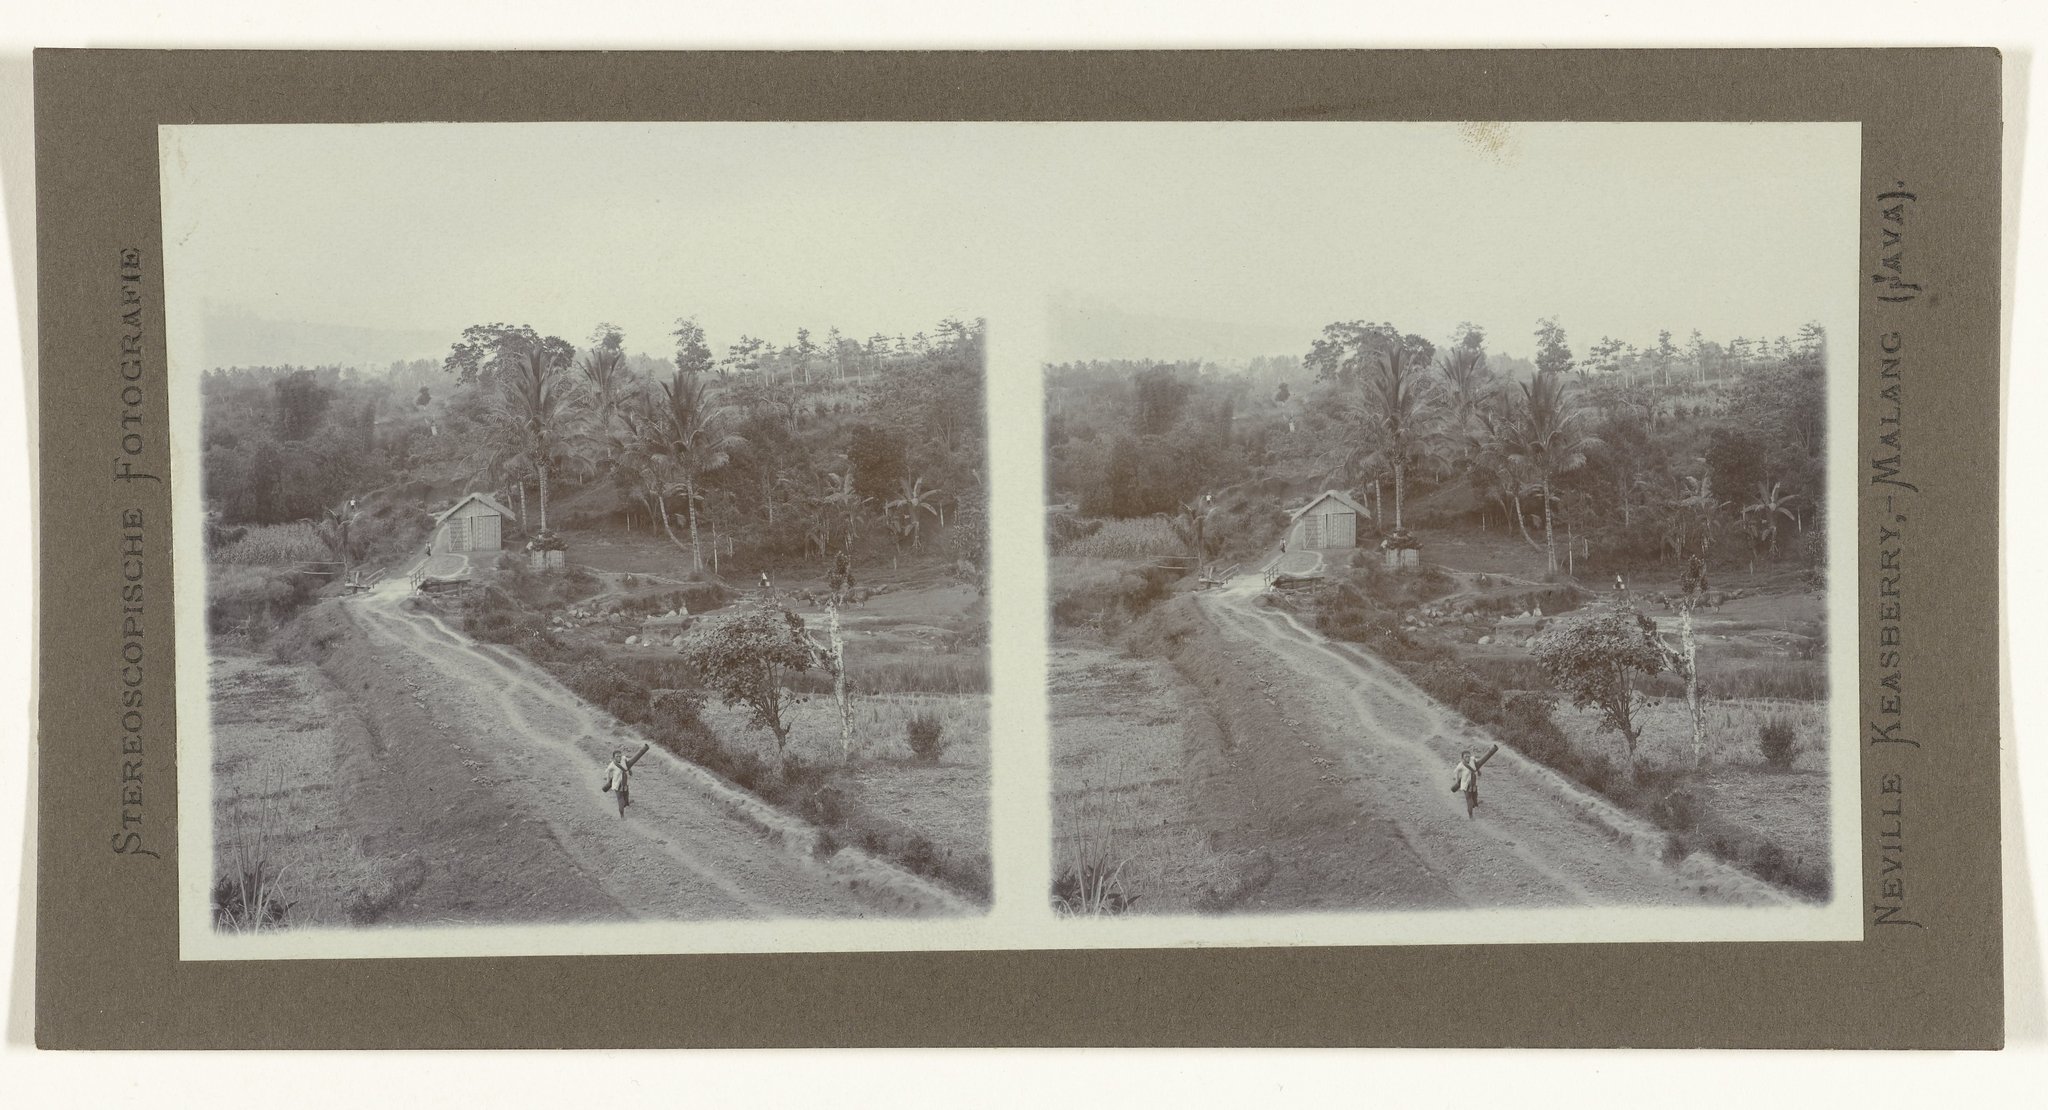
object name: photograph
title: S 8 No 93. Een landschap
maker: neville keasberry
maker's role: fotograaf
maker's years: 1866-1944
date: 1900-1935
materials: cardboard, paper, photographic support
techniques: albumen print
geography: malang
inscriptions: signature: ‘Neville Keasberry, Malang (Java)’, inscription: ‘Stereoscopische Fotografie’